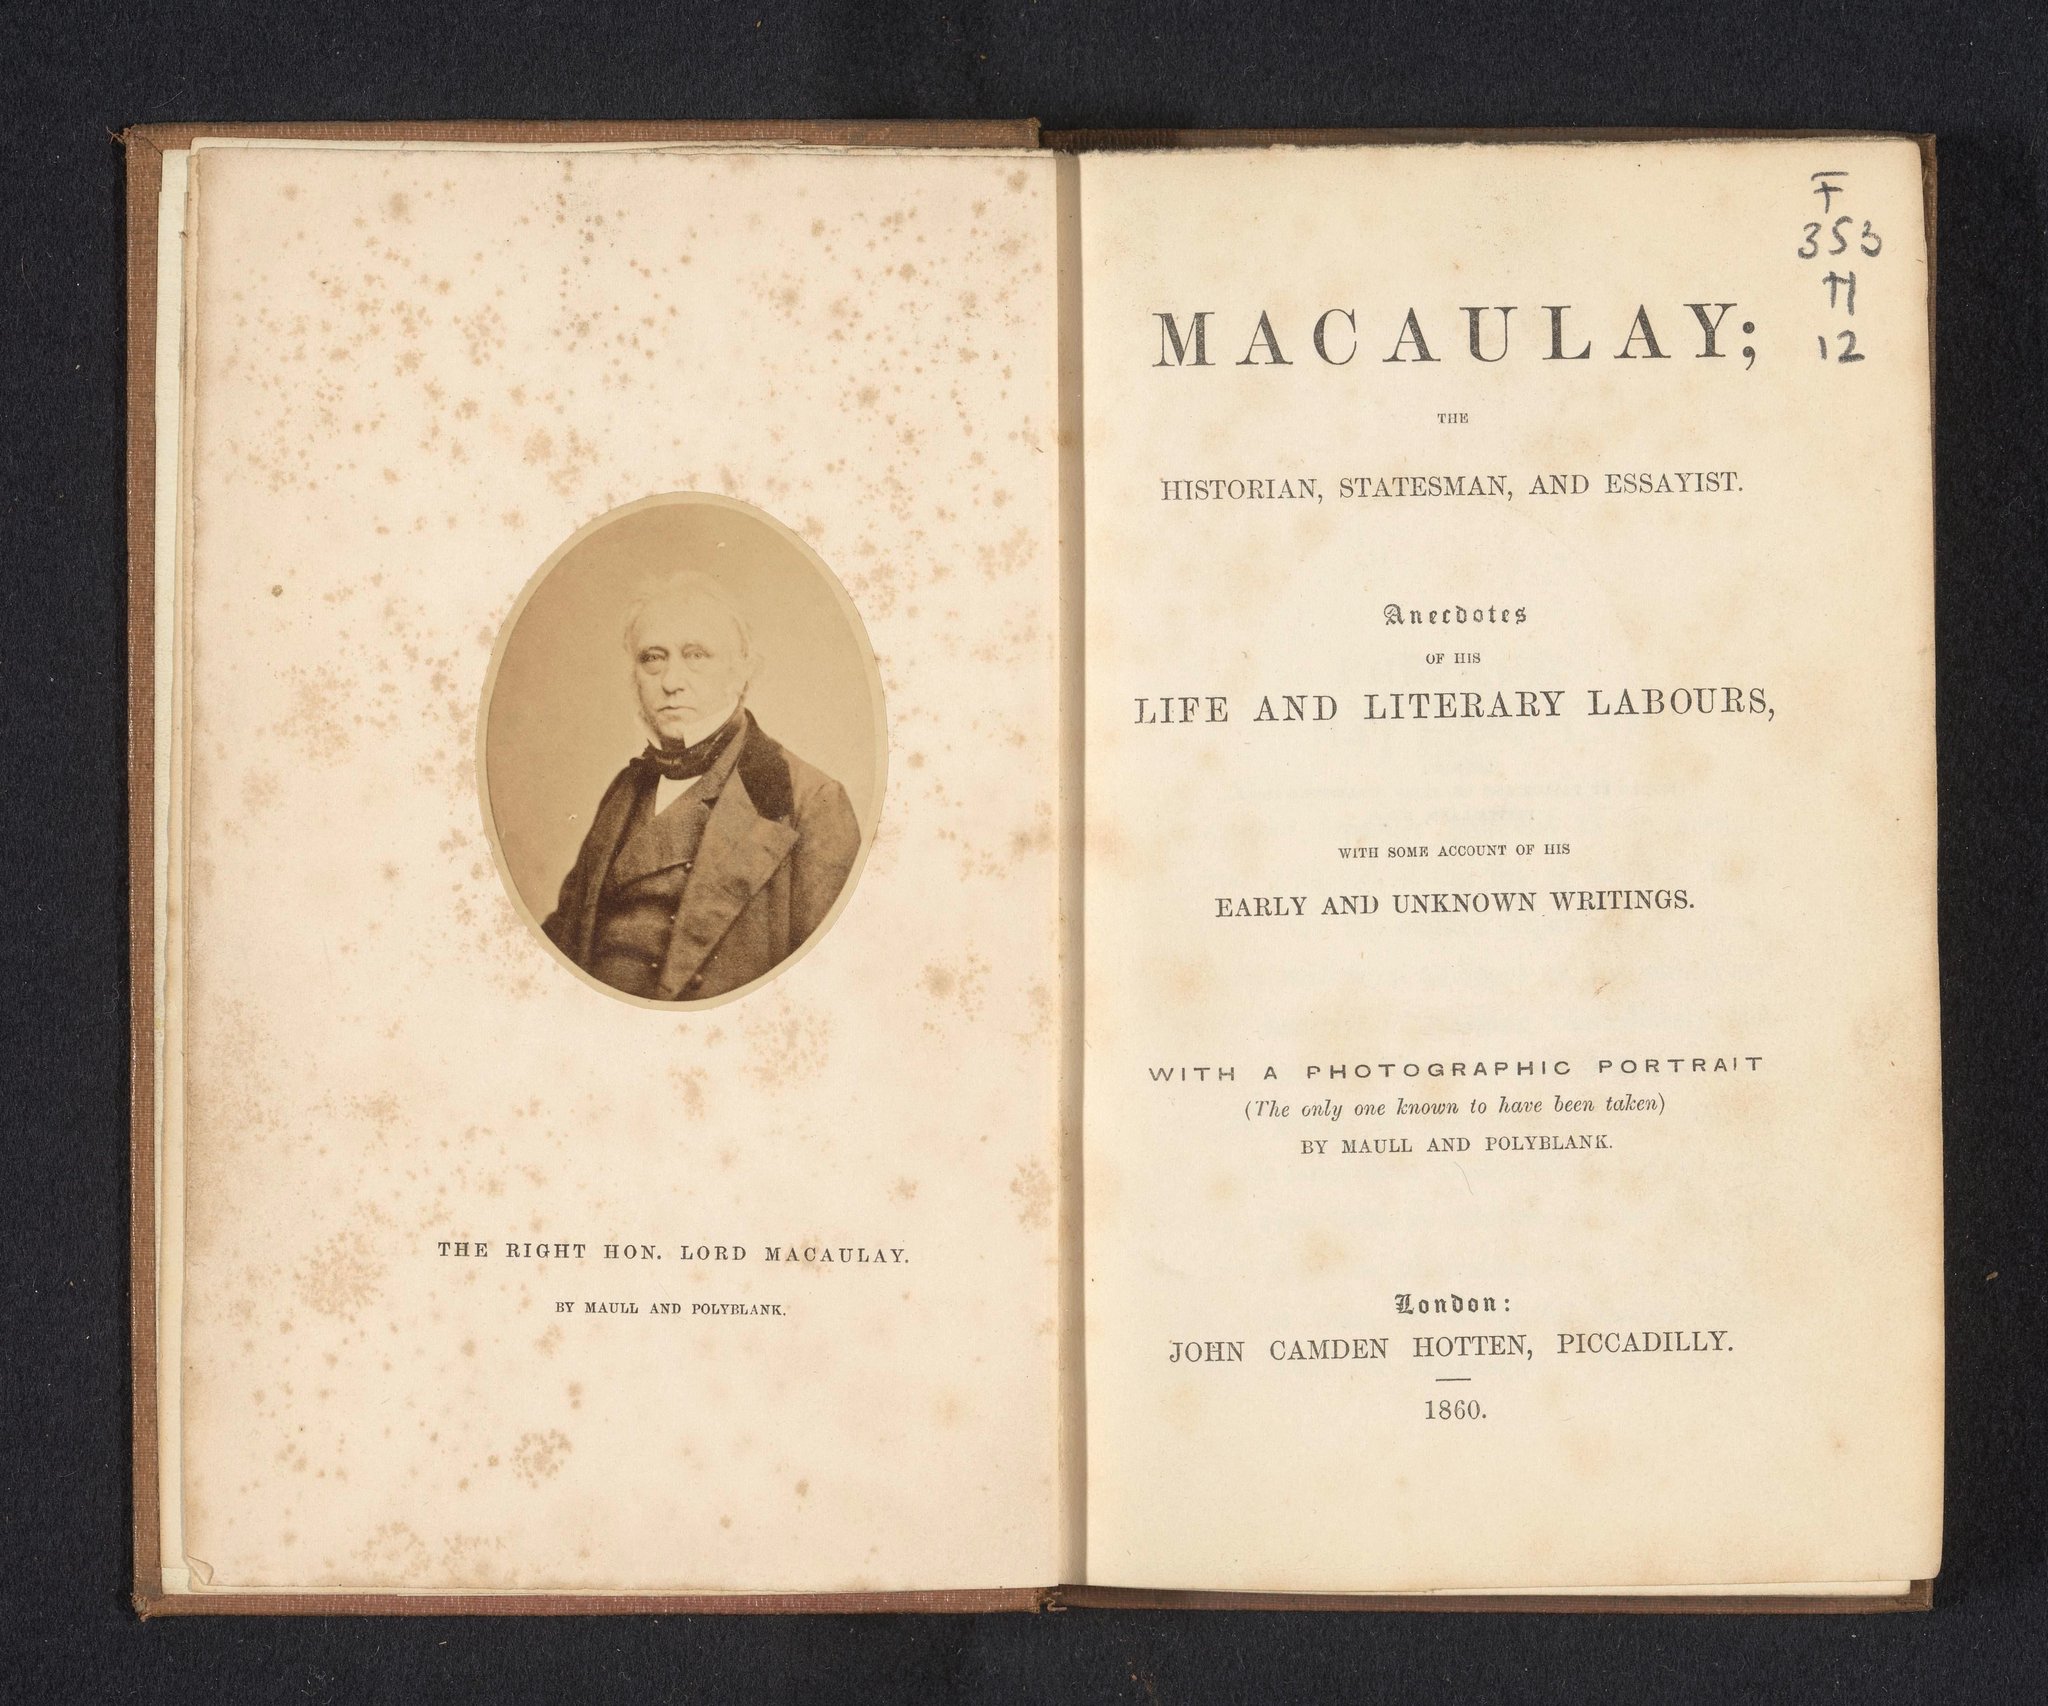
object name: page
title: The right hon. Lord Macaulay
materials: photographic support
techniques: albumen print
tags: london, thomas babington macaulay, politician, e.g. party leader